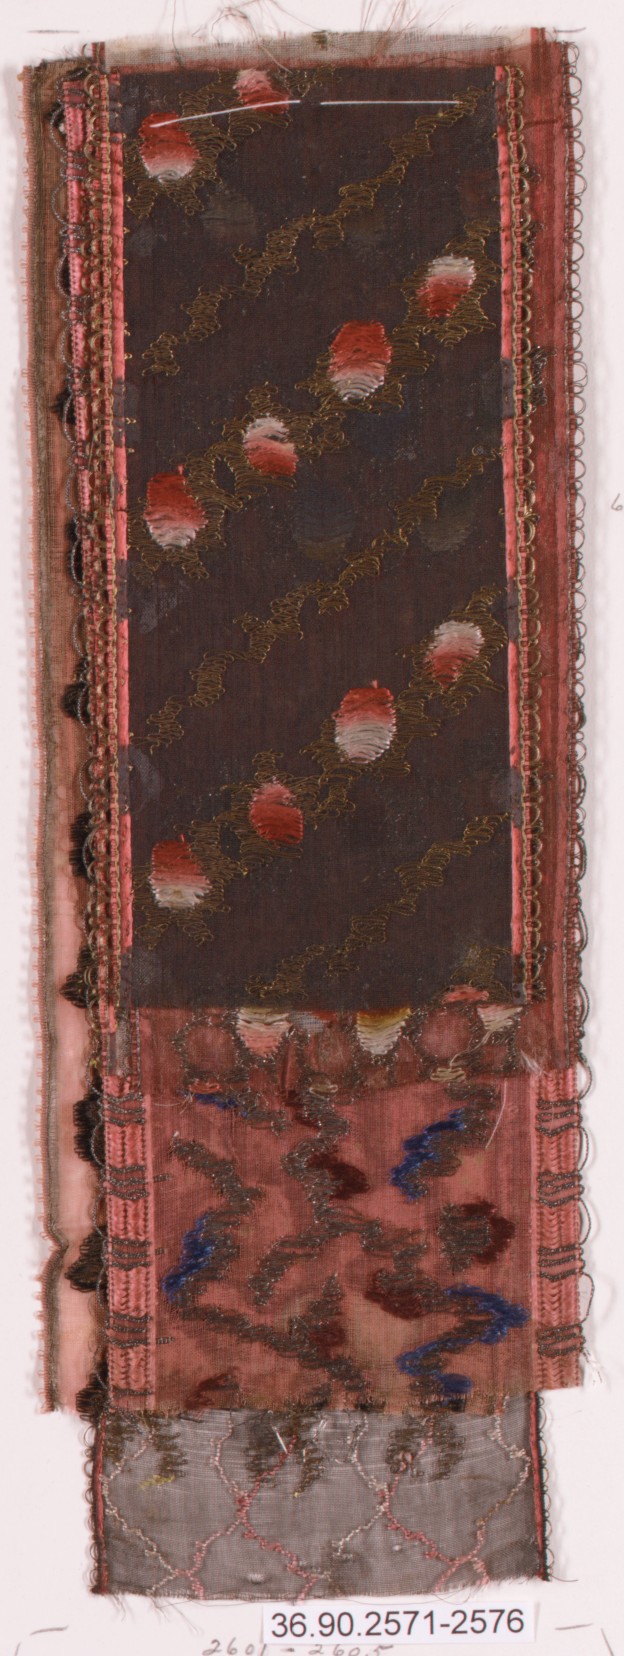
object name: ribbon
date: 1801-1900